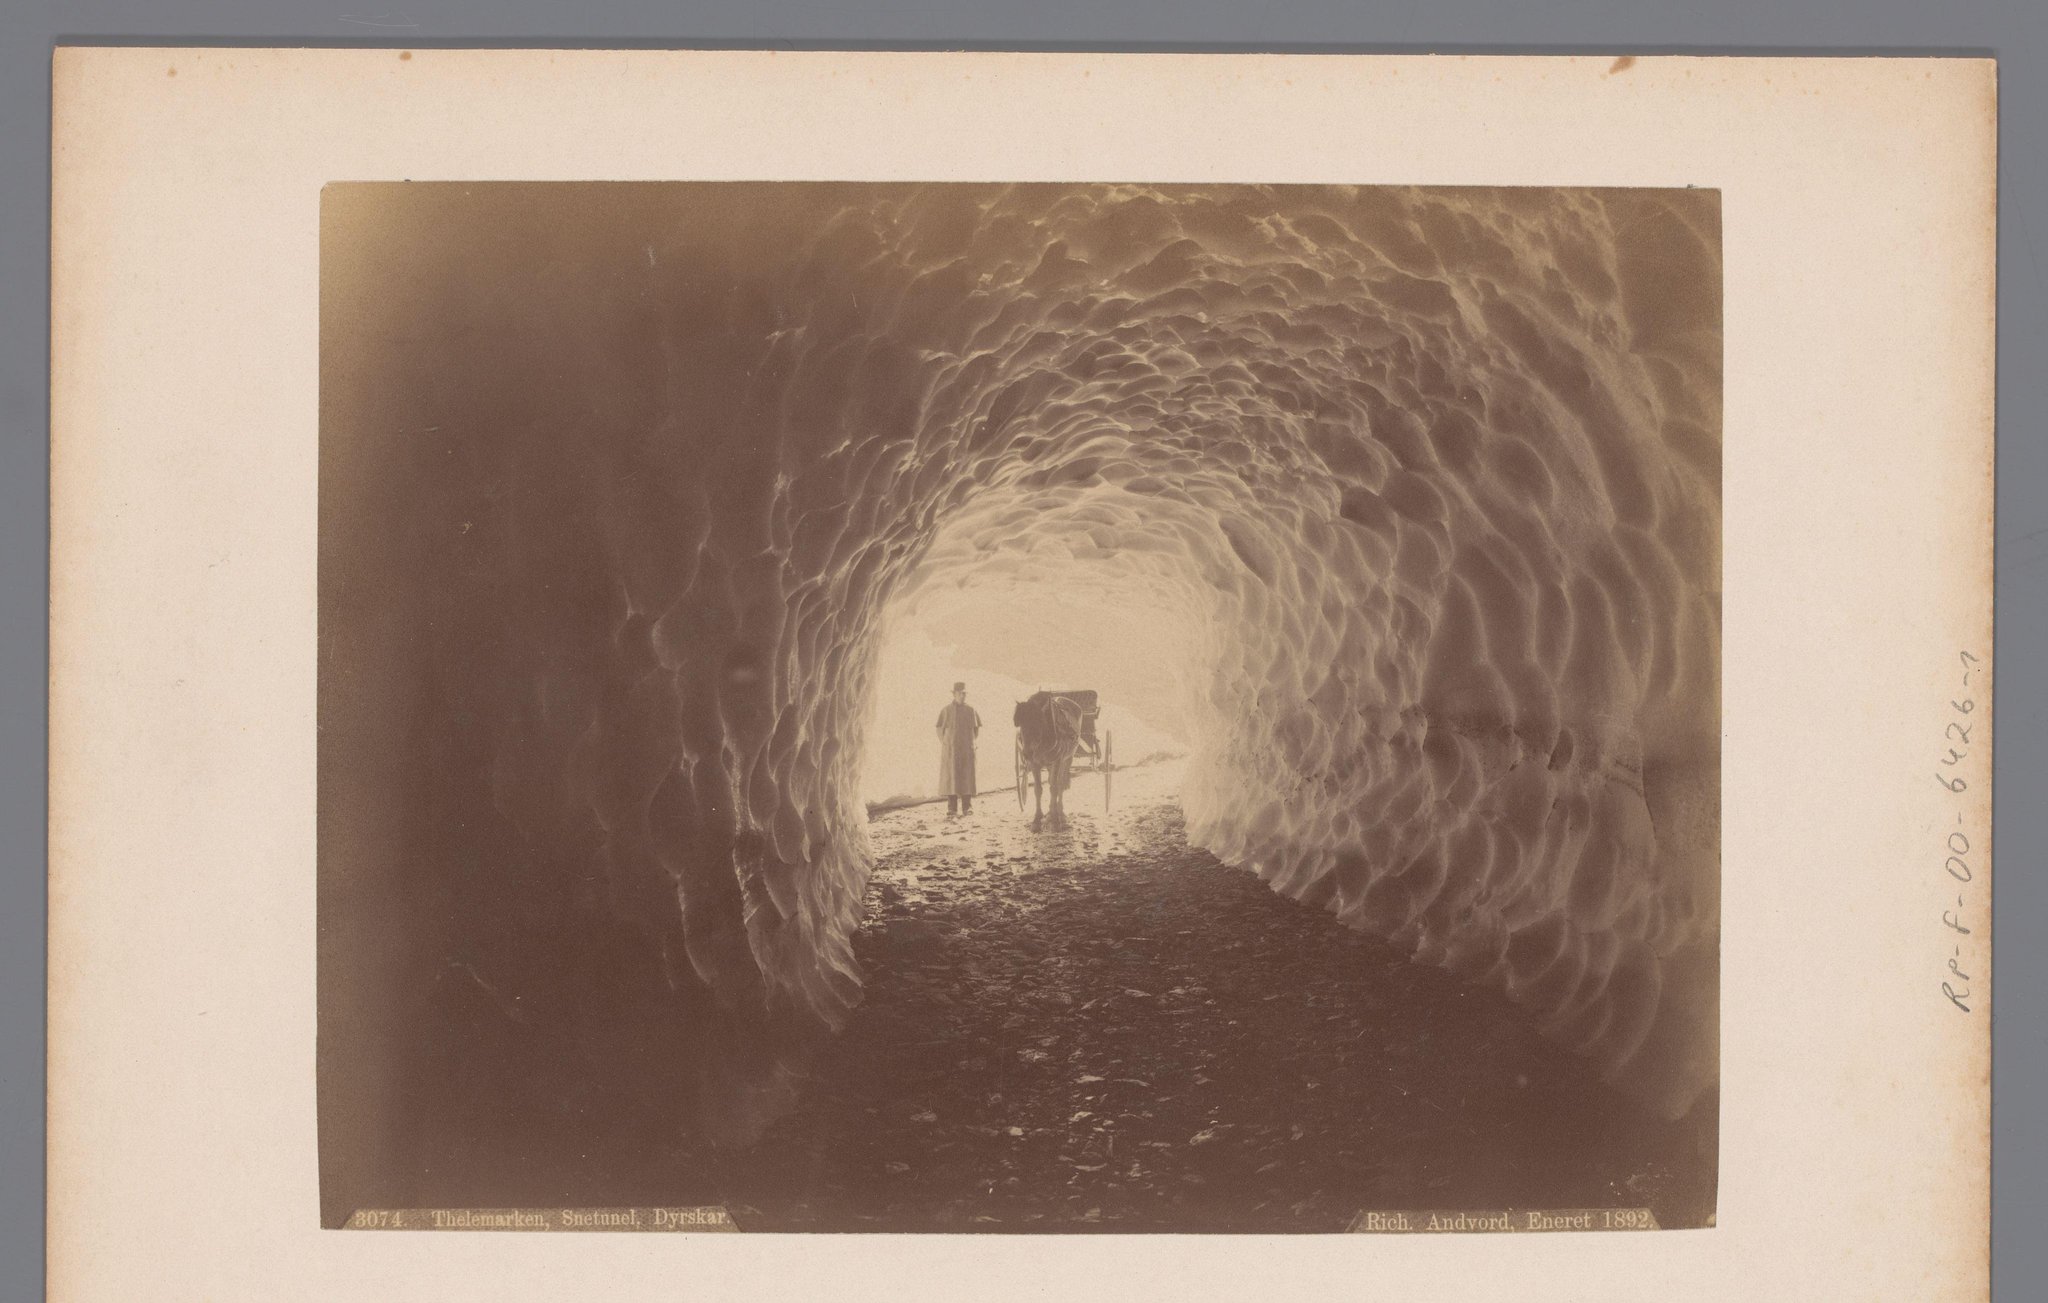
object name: photograph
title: Tunnel van sneeuw, Telemarken, Noorwegen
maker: richard andvord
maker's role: publisher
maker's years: 1839-1913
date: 1892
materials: cardboard, photographic support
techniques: albumen print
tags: norway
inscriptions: inscription: ‘Rich. Andvord. Eneret 1892.’, caption: ‘3074. Thelemarken, Snetunel, Dyrskar.’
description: Tunnel van sneeuw, met aan het einde een kar met wagenmenner.